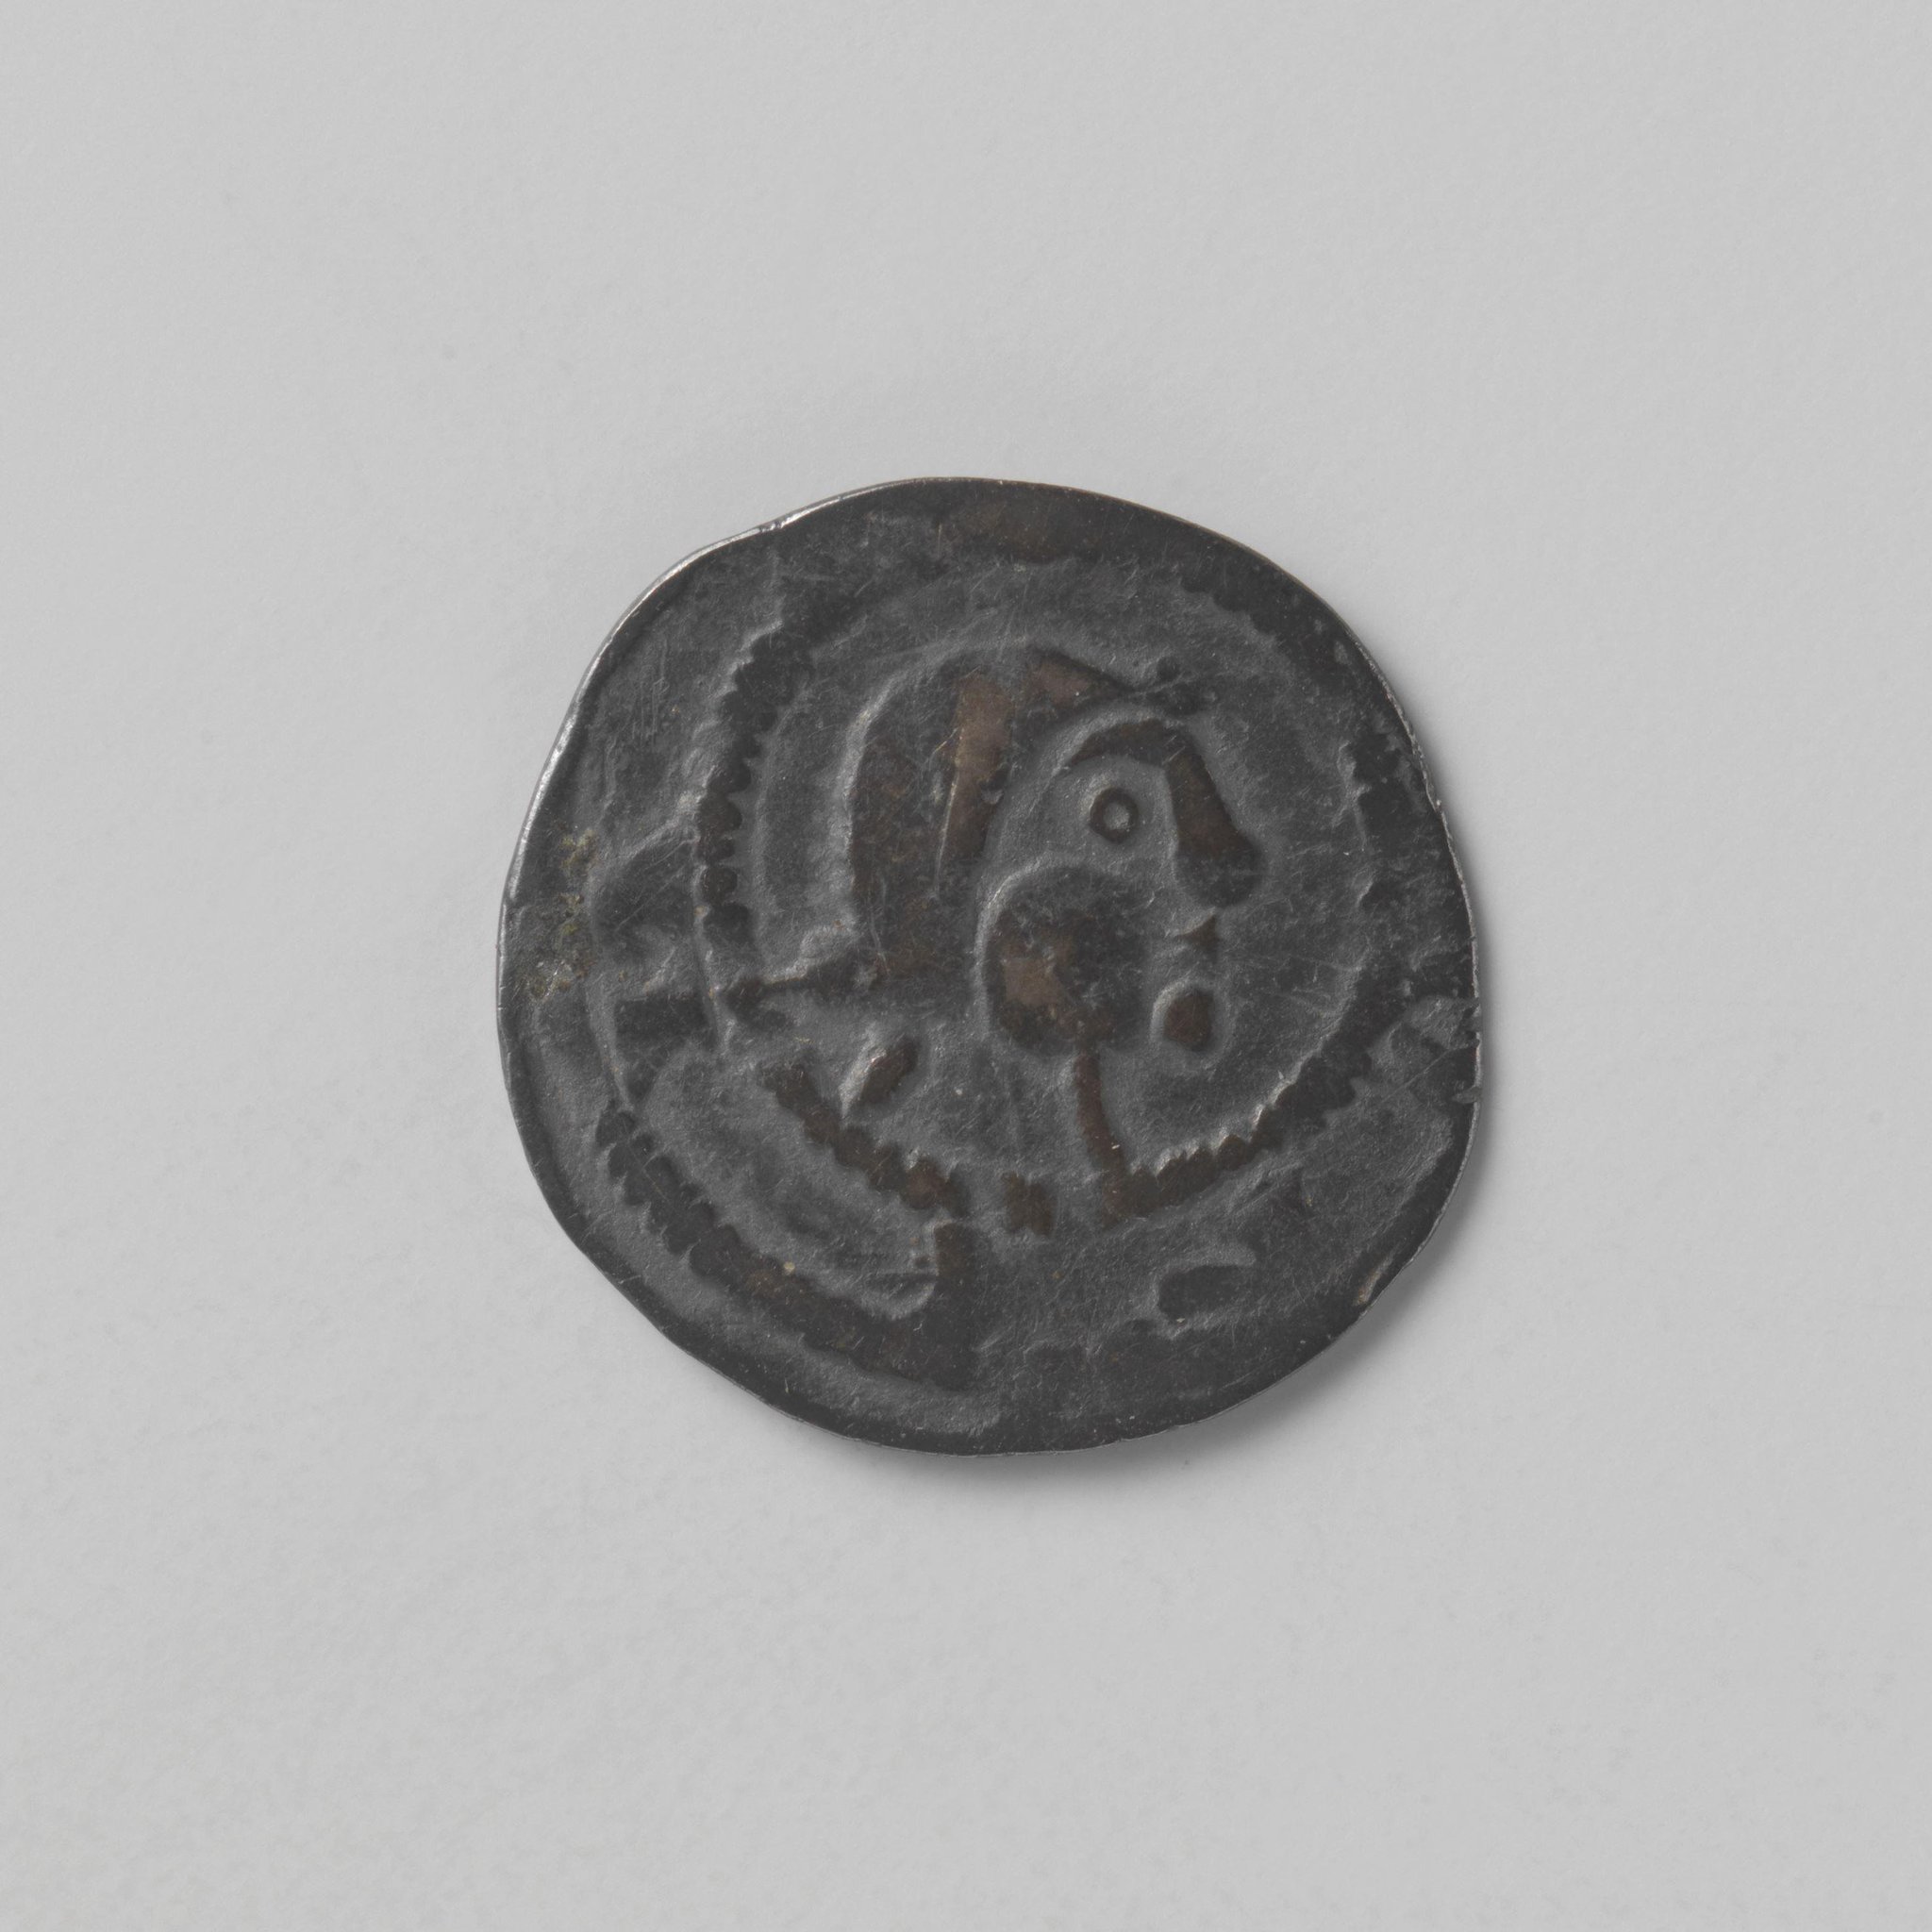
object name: coin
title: Holland, Floris V, penning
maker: floris v (graaf van holland en zeeland)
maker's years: 1254-1296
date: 1256-1258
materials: silver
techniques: striking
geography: dordrecht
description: Zilveren munt. Voorzijde: hoofd met gravenmuts naar rechts. Keerzijde: lang dubbellijnig kruis.